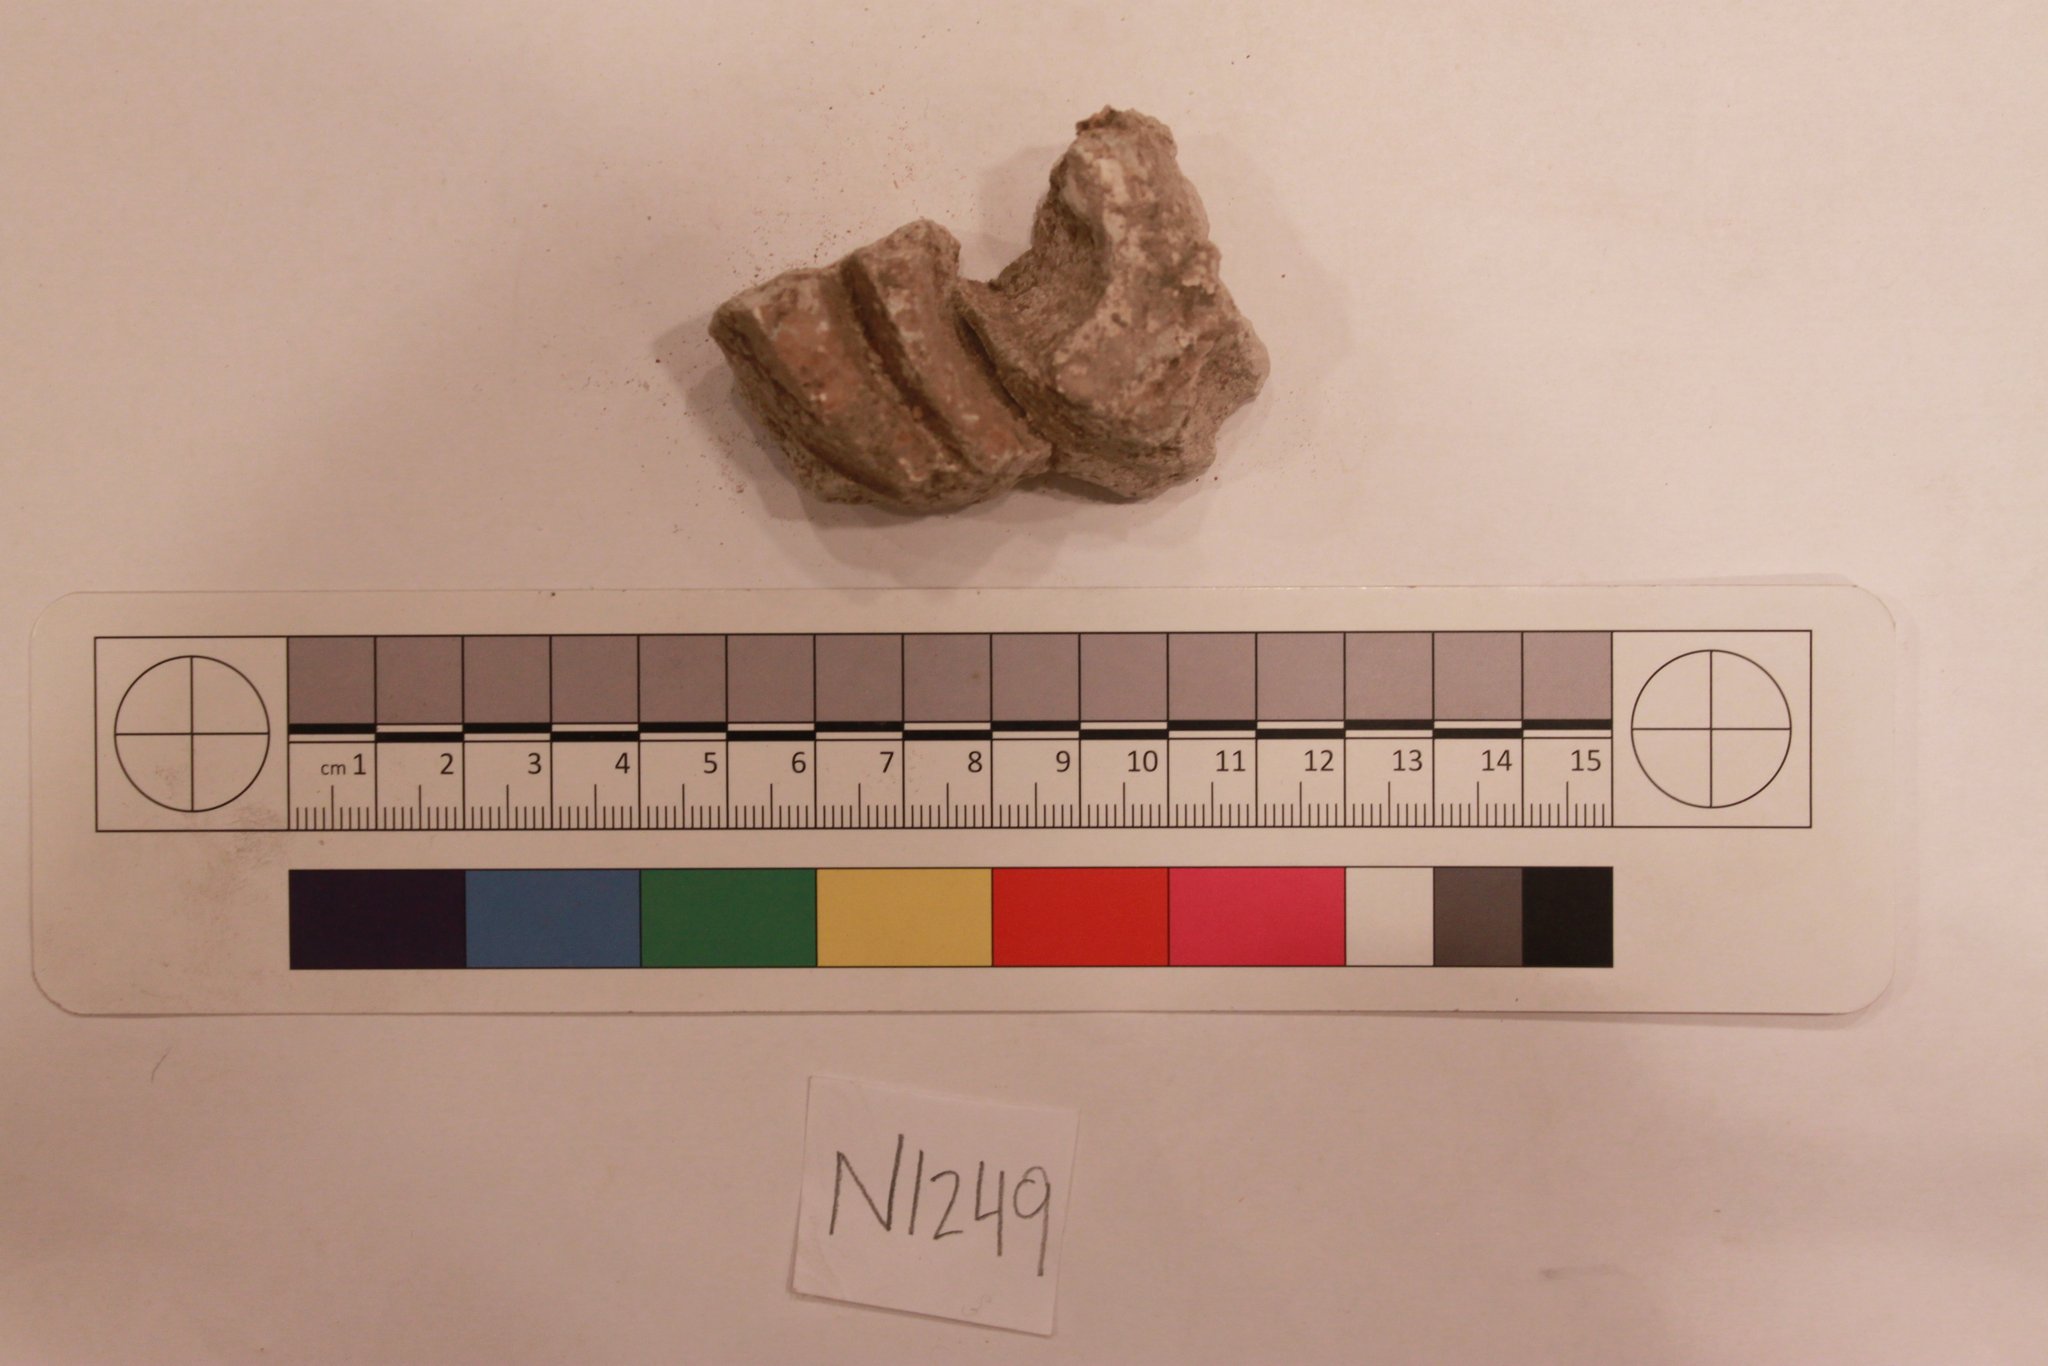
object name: fragment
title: Stucco Fragment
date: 701-1200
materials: plaster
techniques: carving, painting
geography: iran